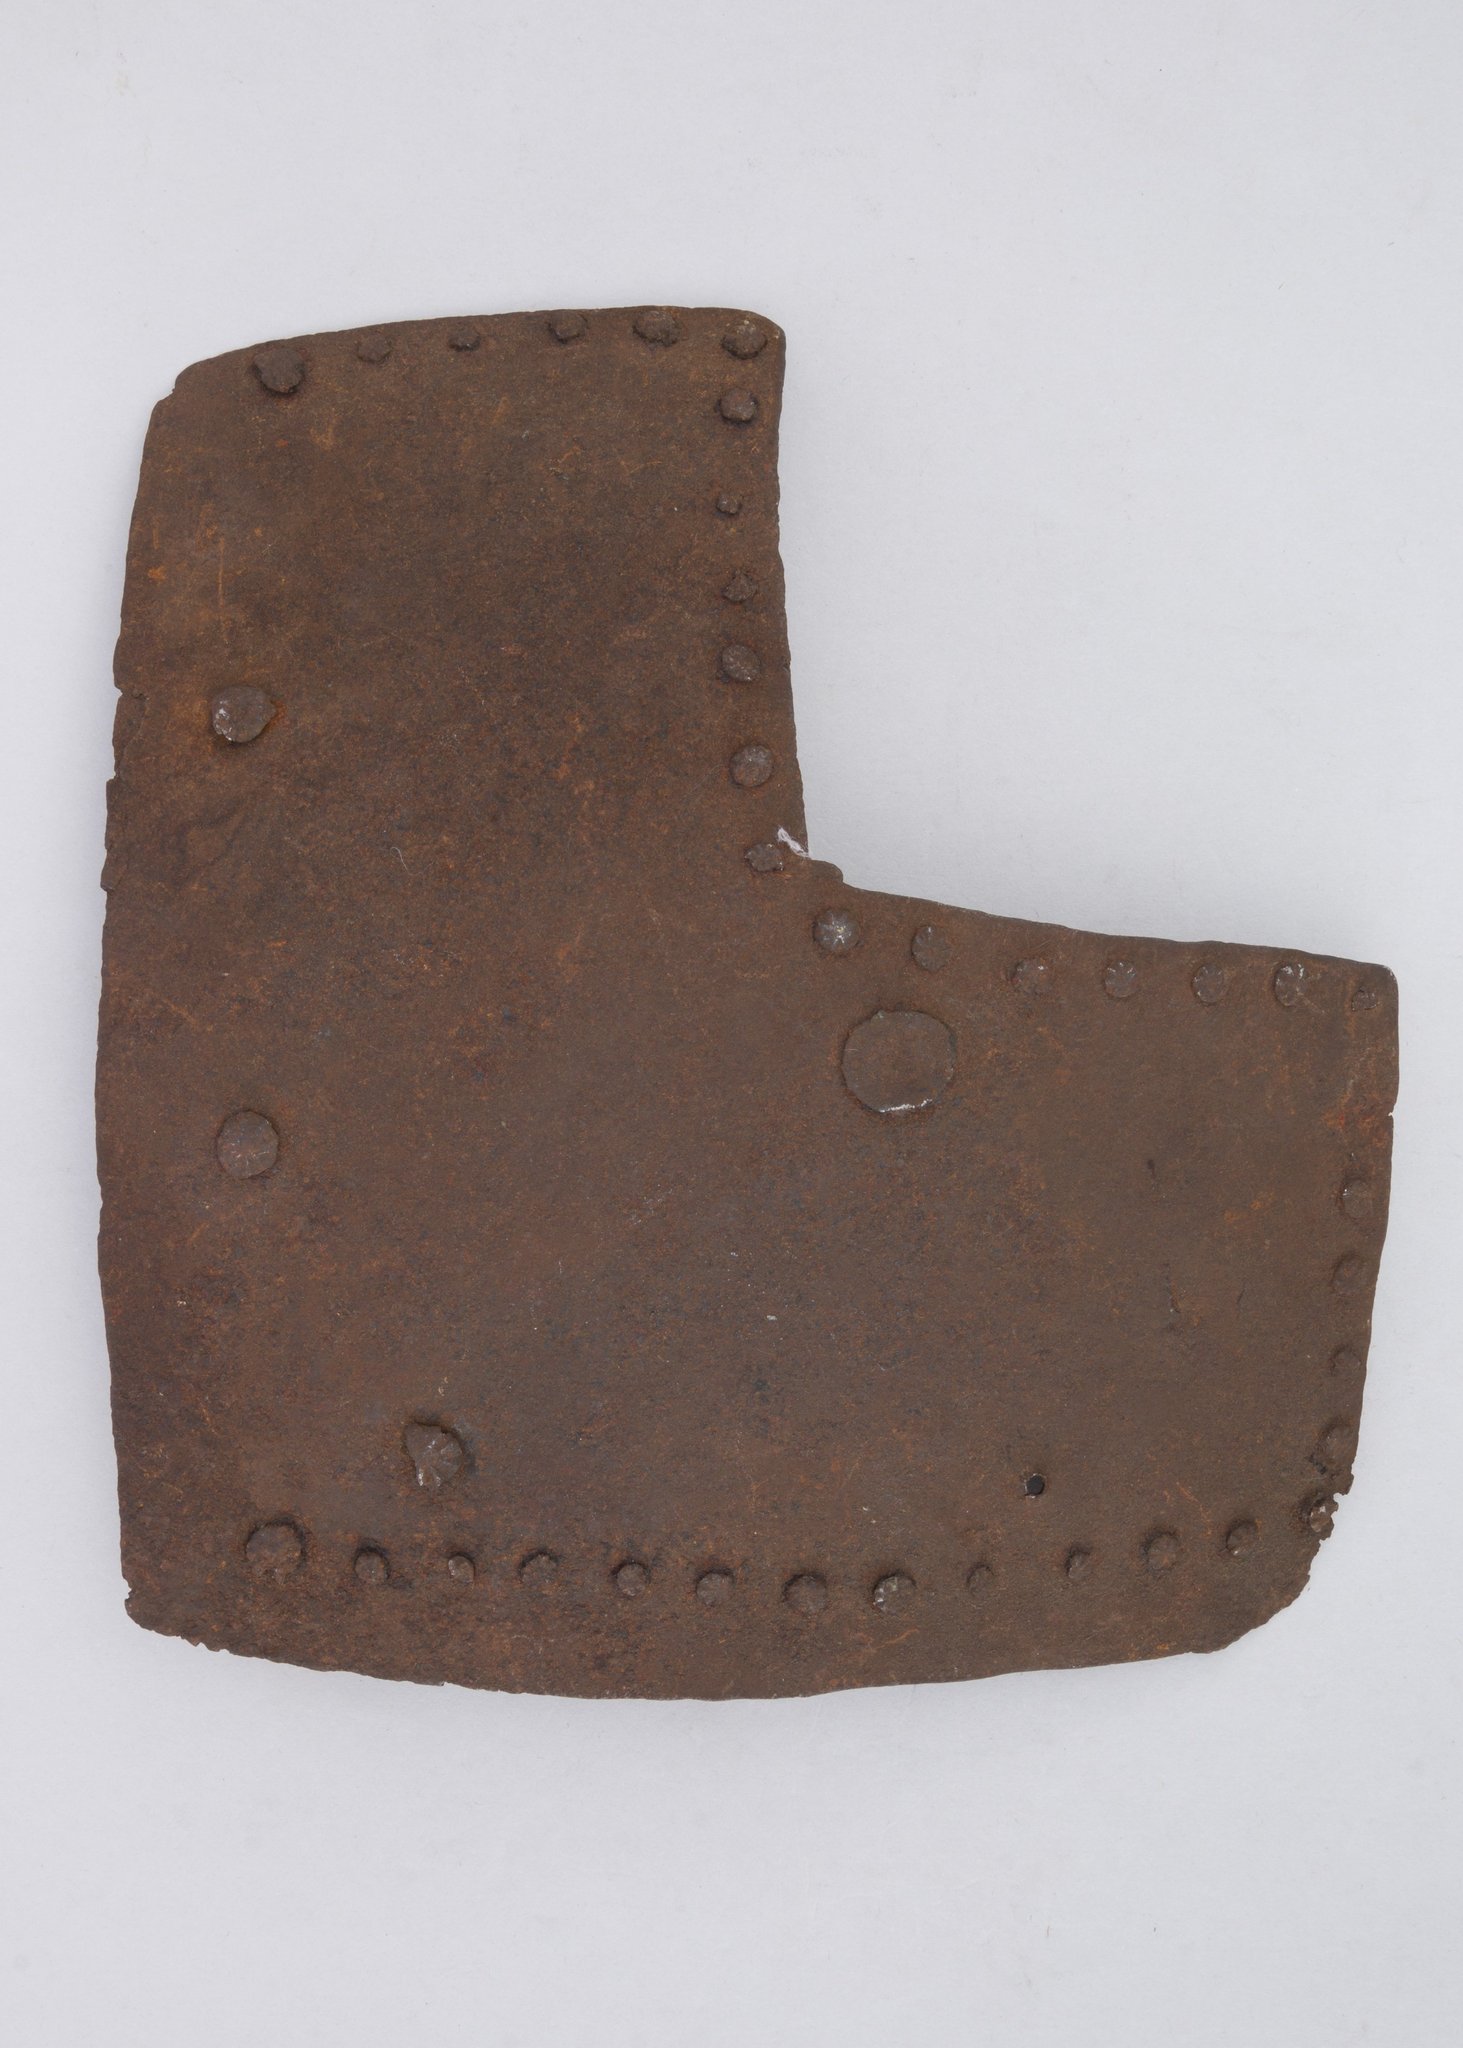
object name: brigandine plate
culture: italian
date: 1400-1450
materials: metal alloy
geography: italy